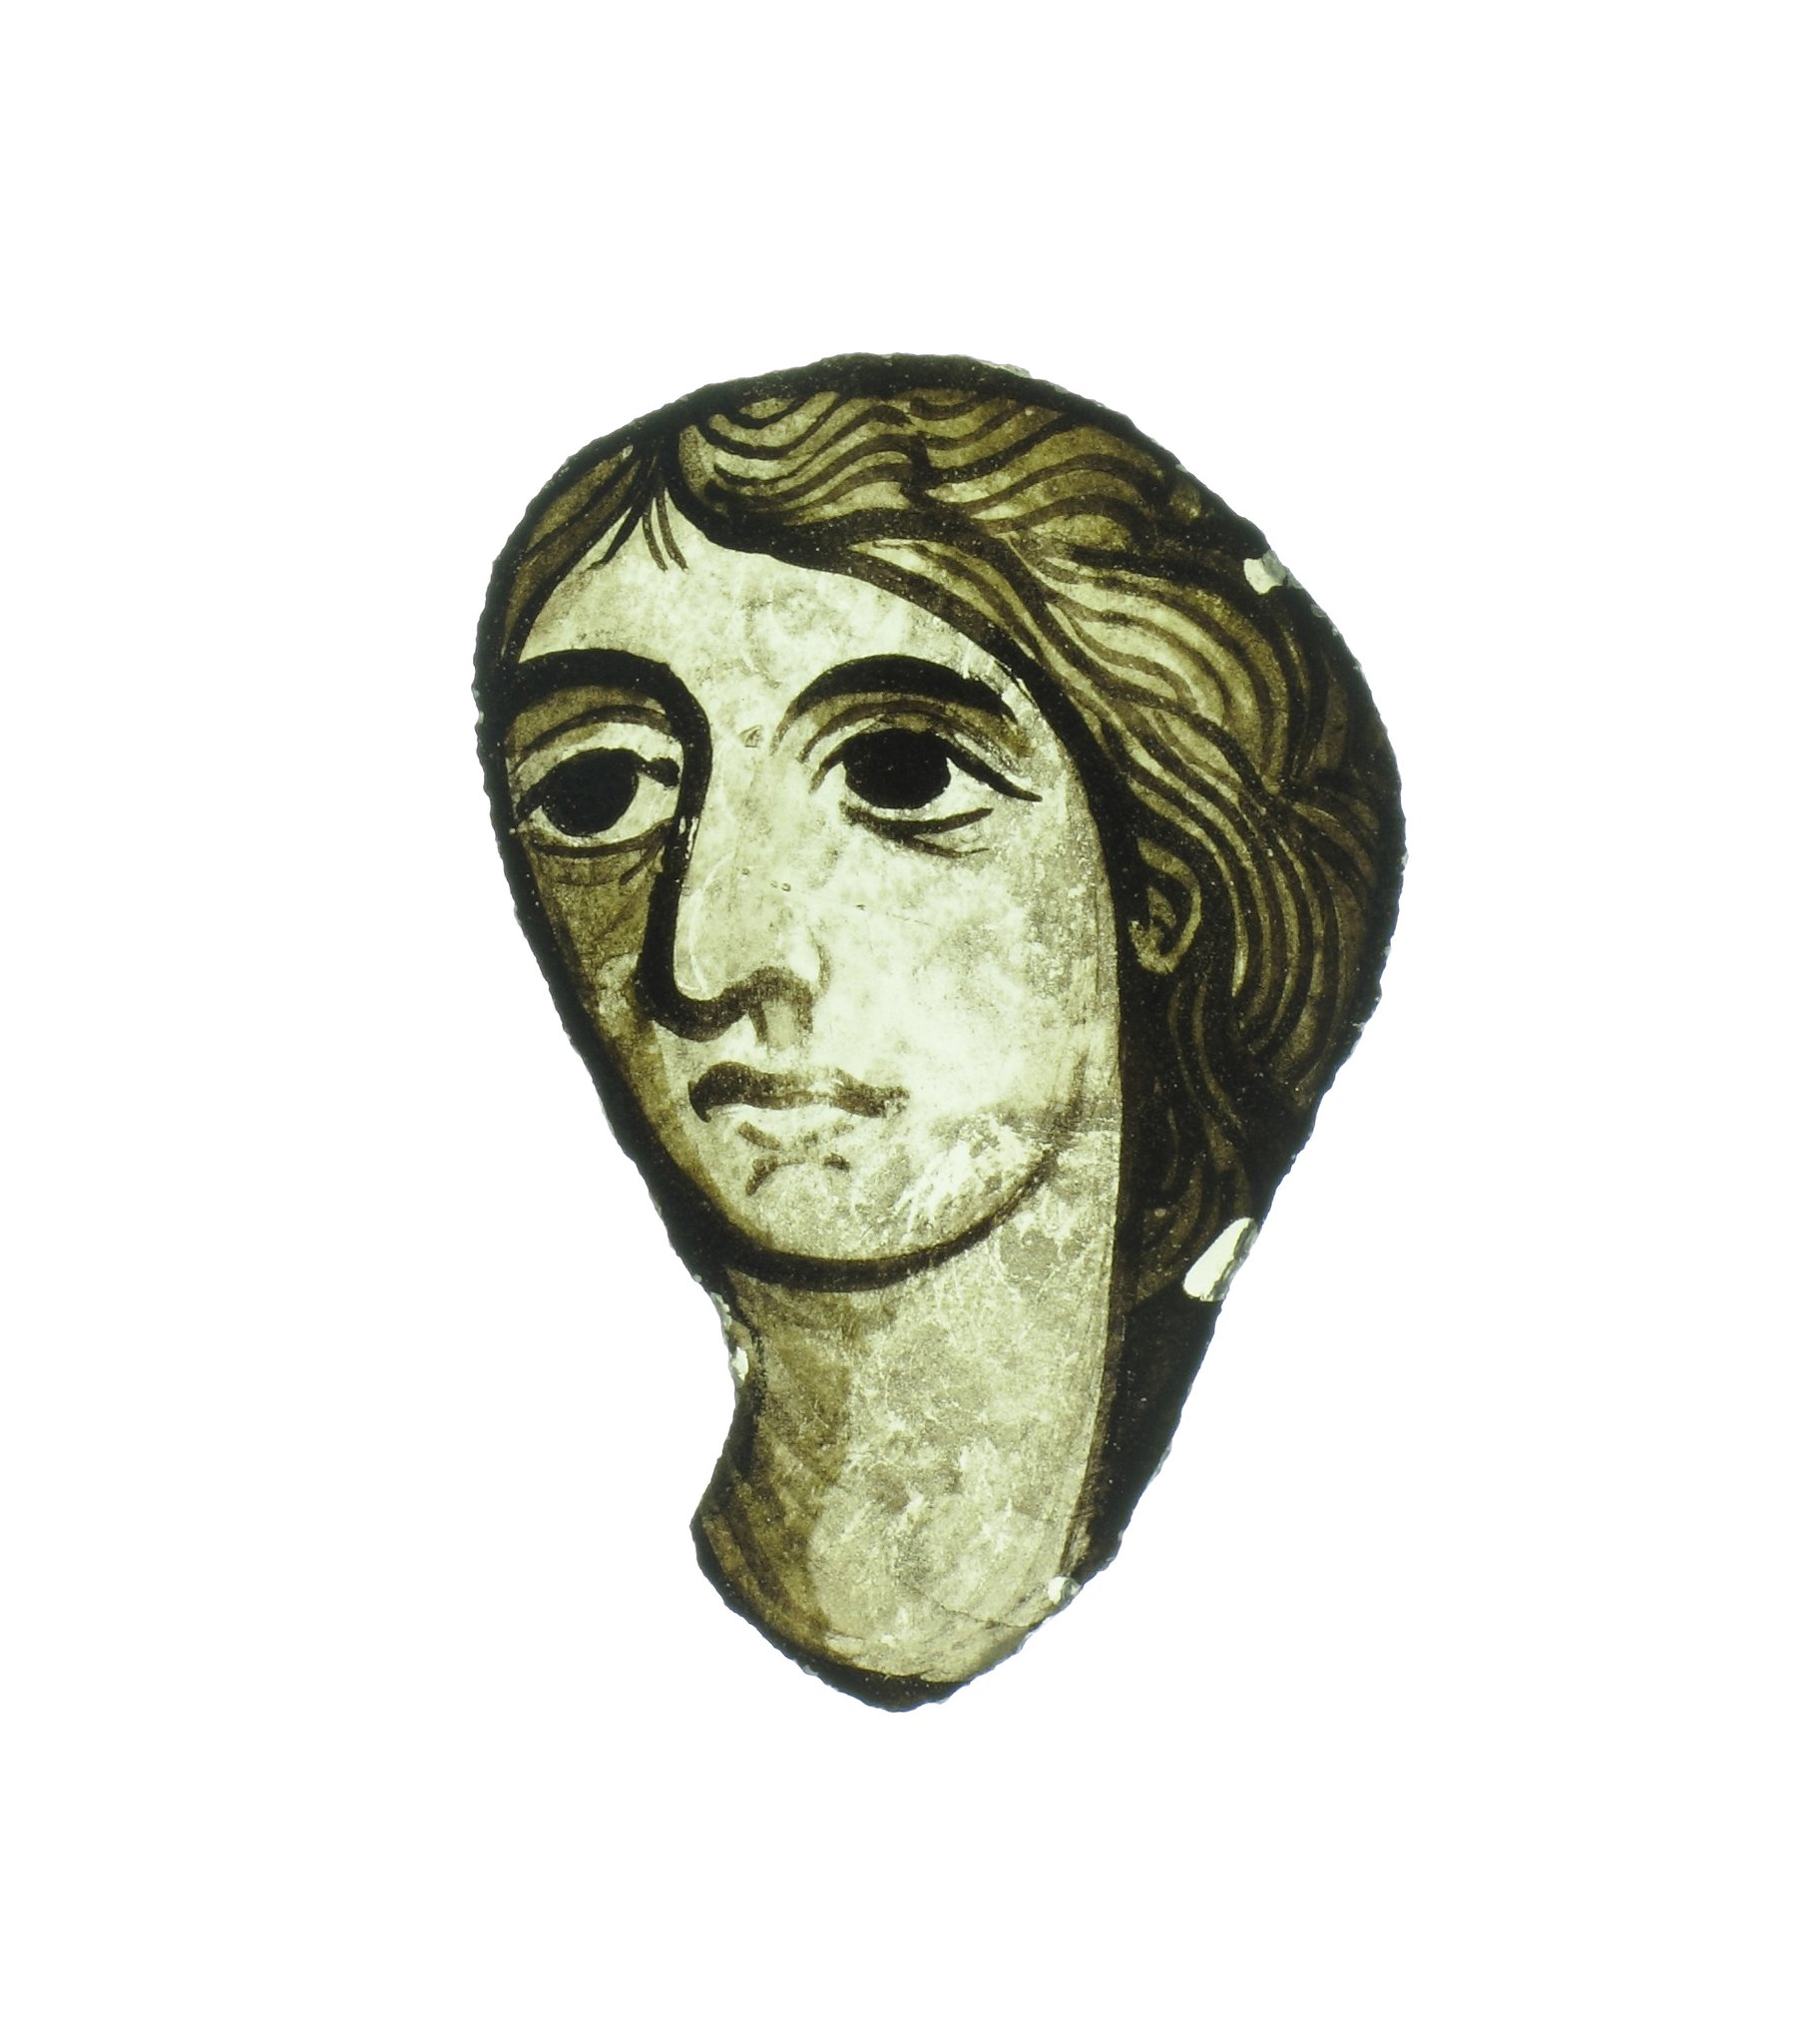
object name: fragment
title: Glass Fragment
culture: french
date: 1101-1400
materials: glass, metal, paint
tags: heads